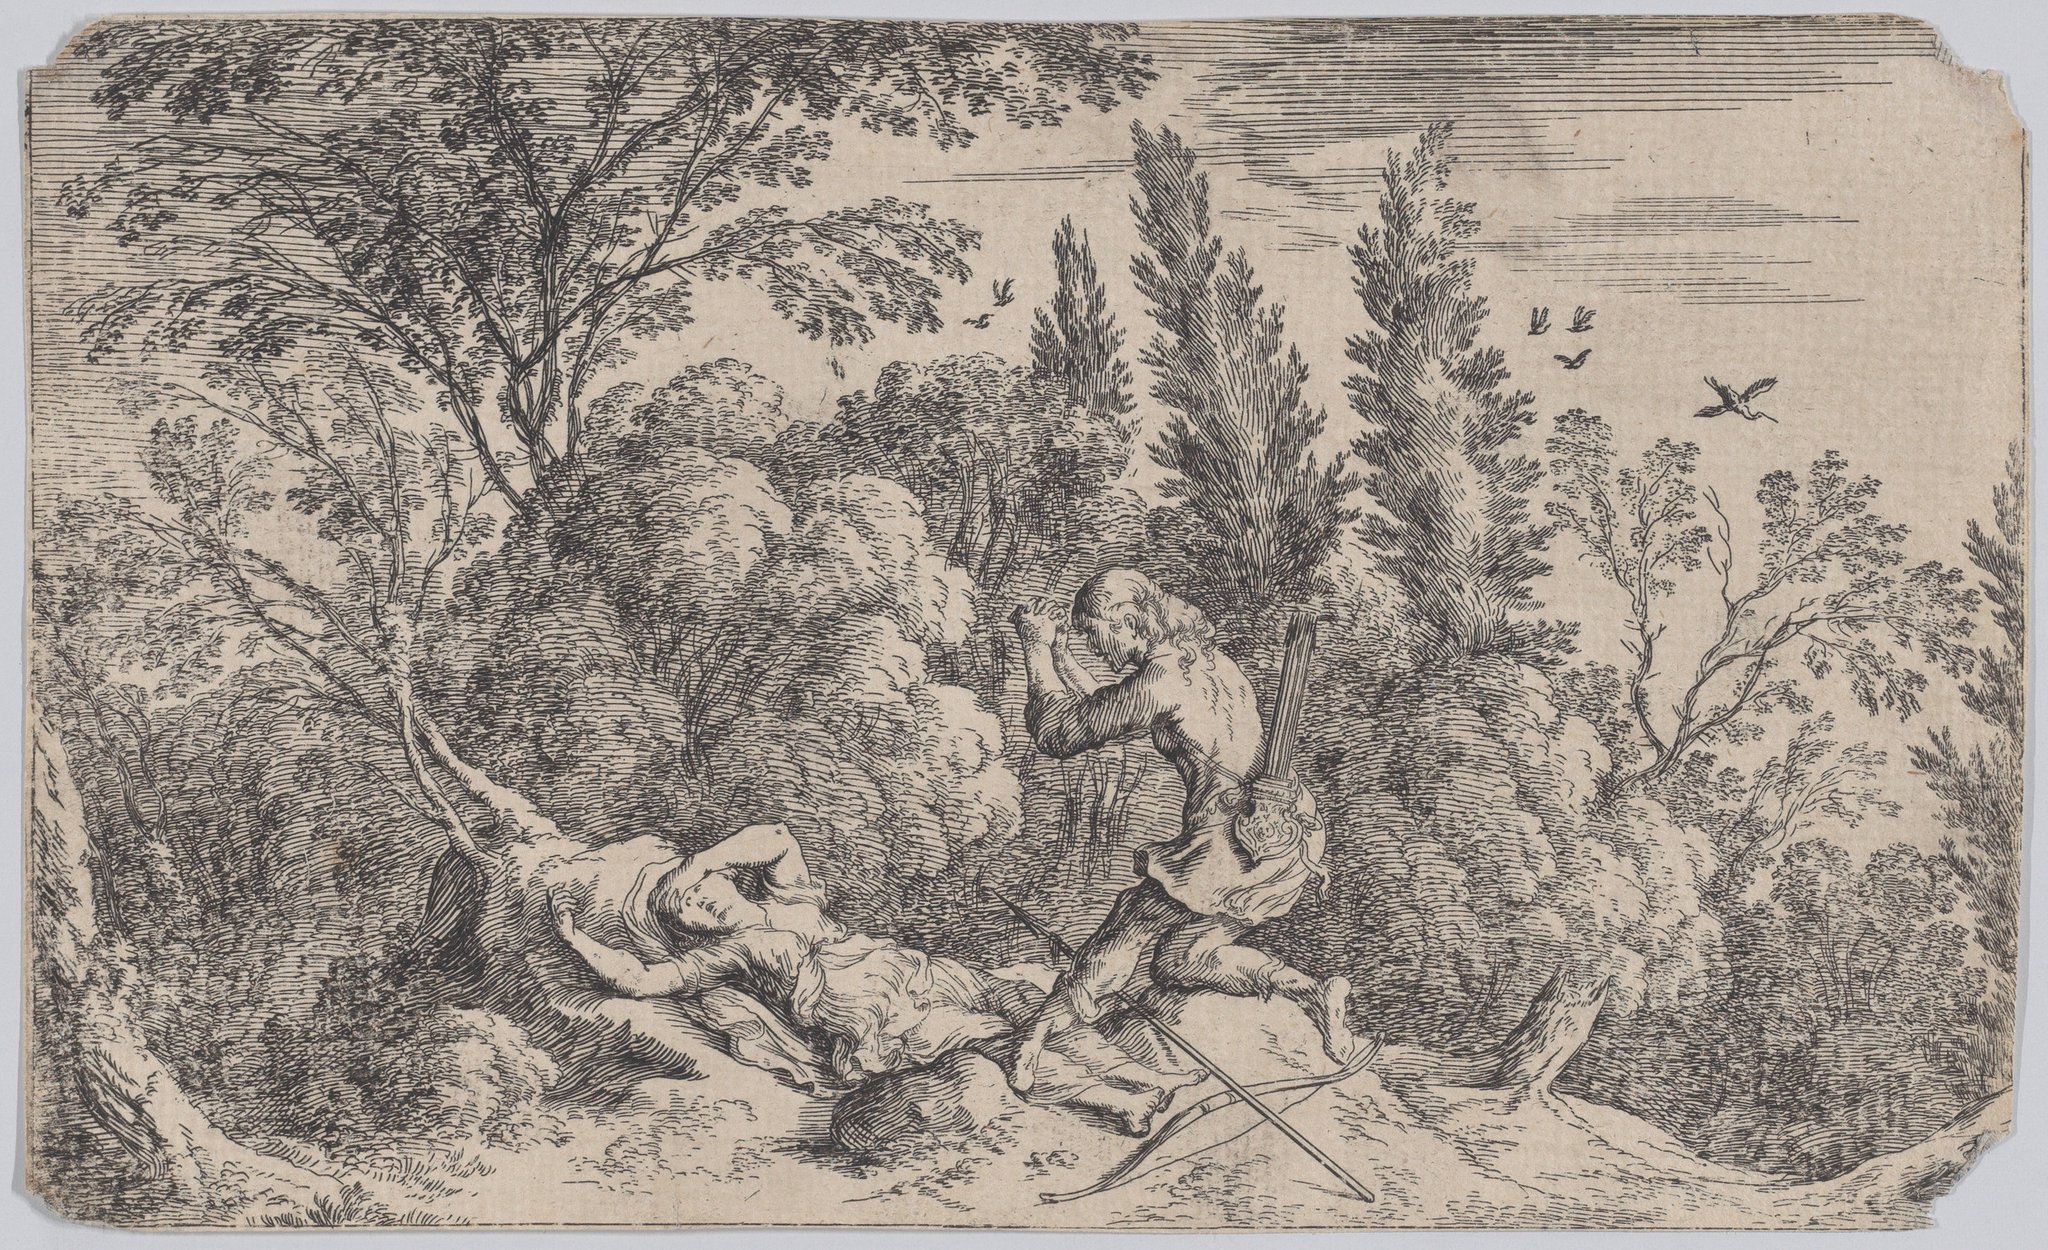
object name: print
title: Cephalus and Procris, plate 70 from "Ovid's Metamorphoses"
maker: johann wilhelm baur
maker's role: artist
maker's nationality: german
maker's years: 1607-1642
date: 1641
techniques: etching